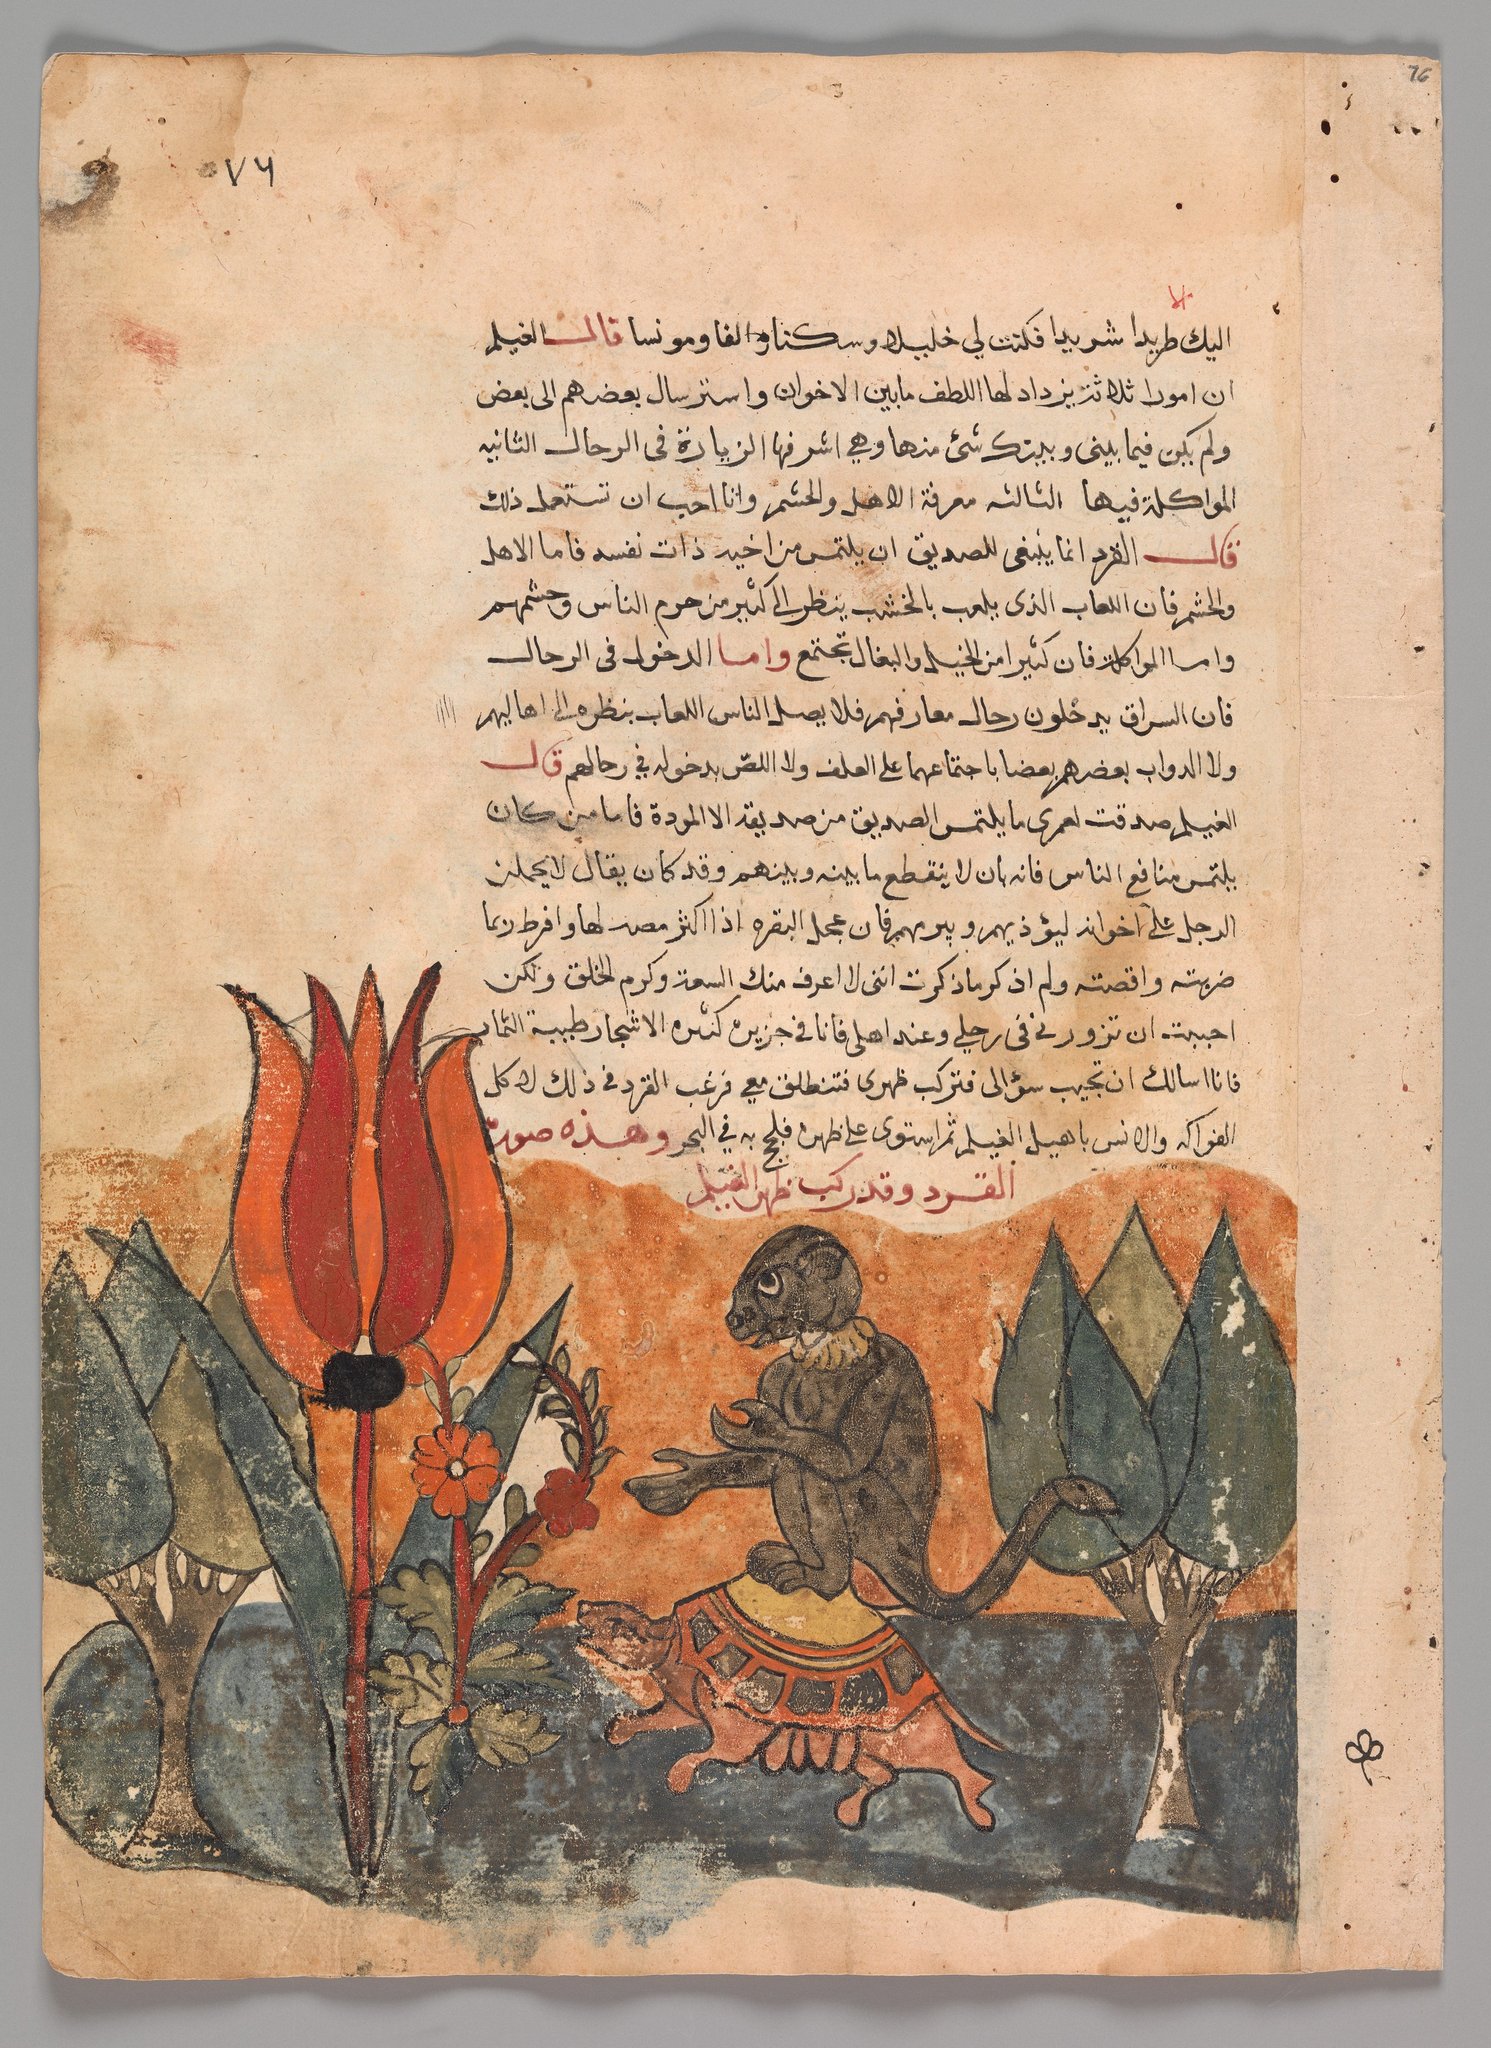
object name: folio from an illustrated manuscript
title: "The Tortoise Ferries the Monkey", Folio from a Kalila wa Dimna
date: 1526-1550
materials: ink, paper, watercolor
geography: india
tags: monkeys,turtles,trees